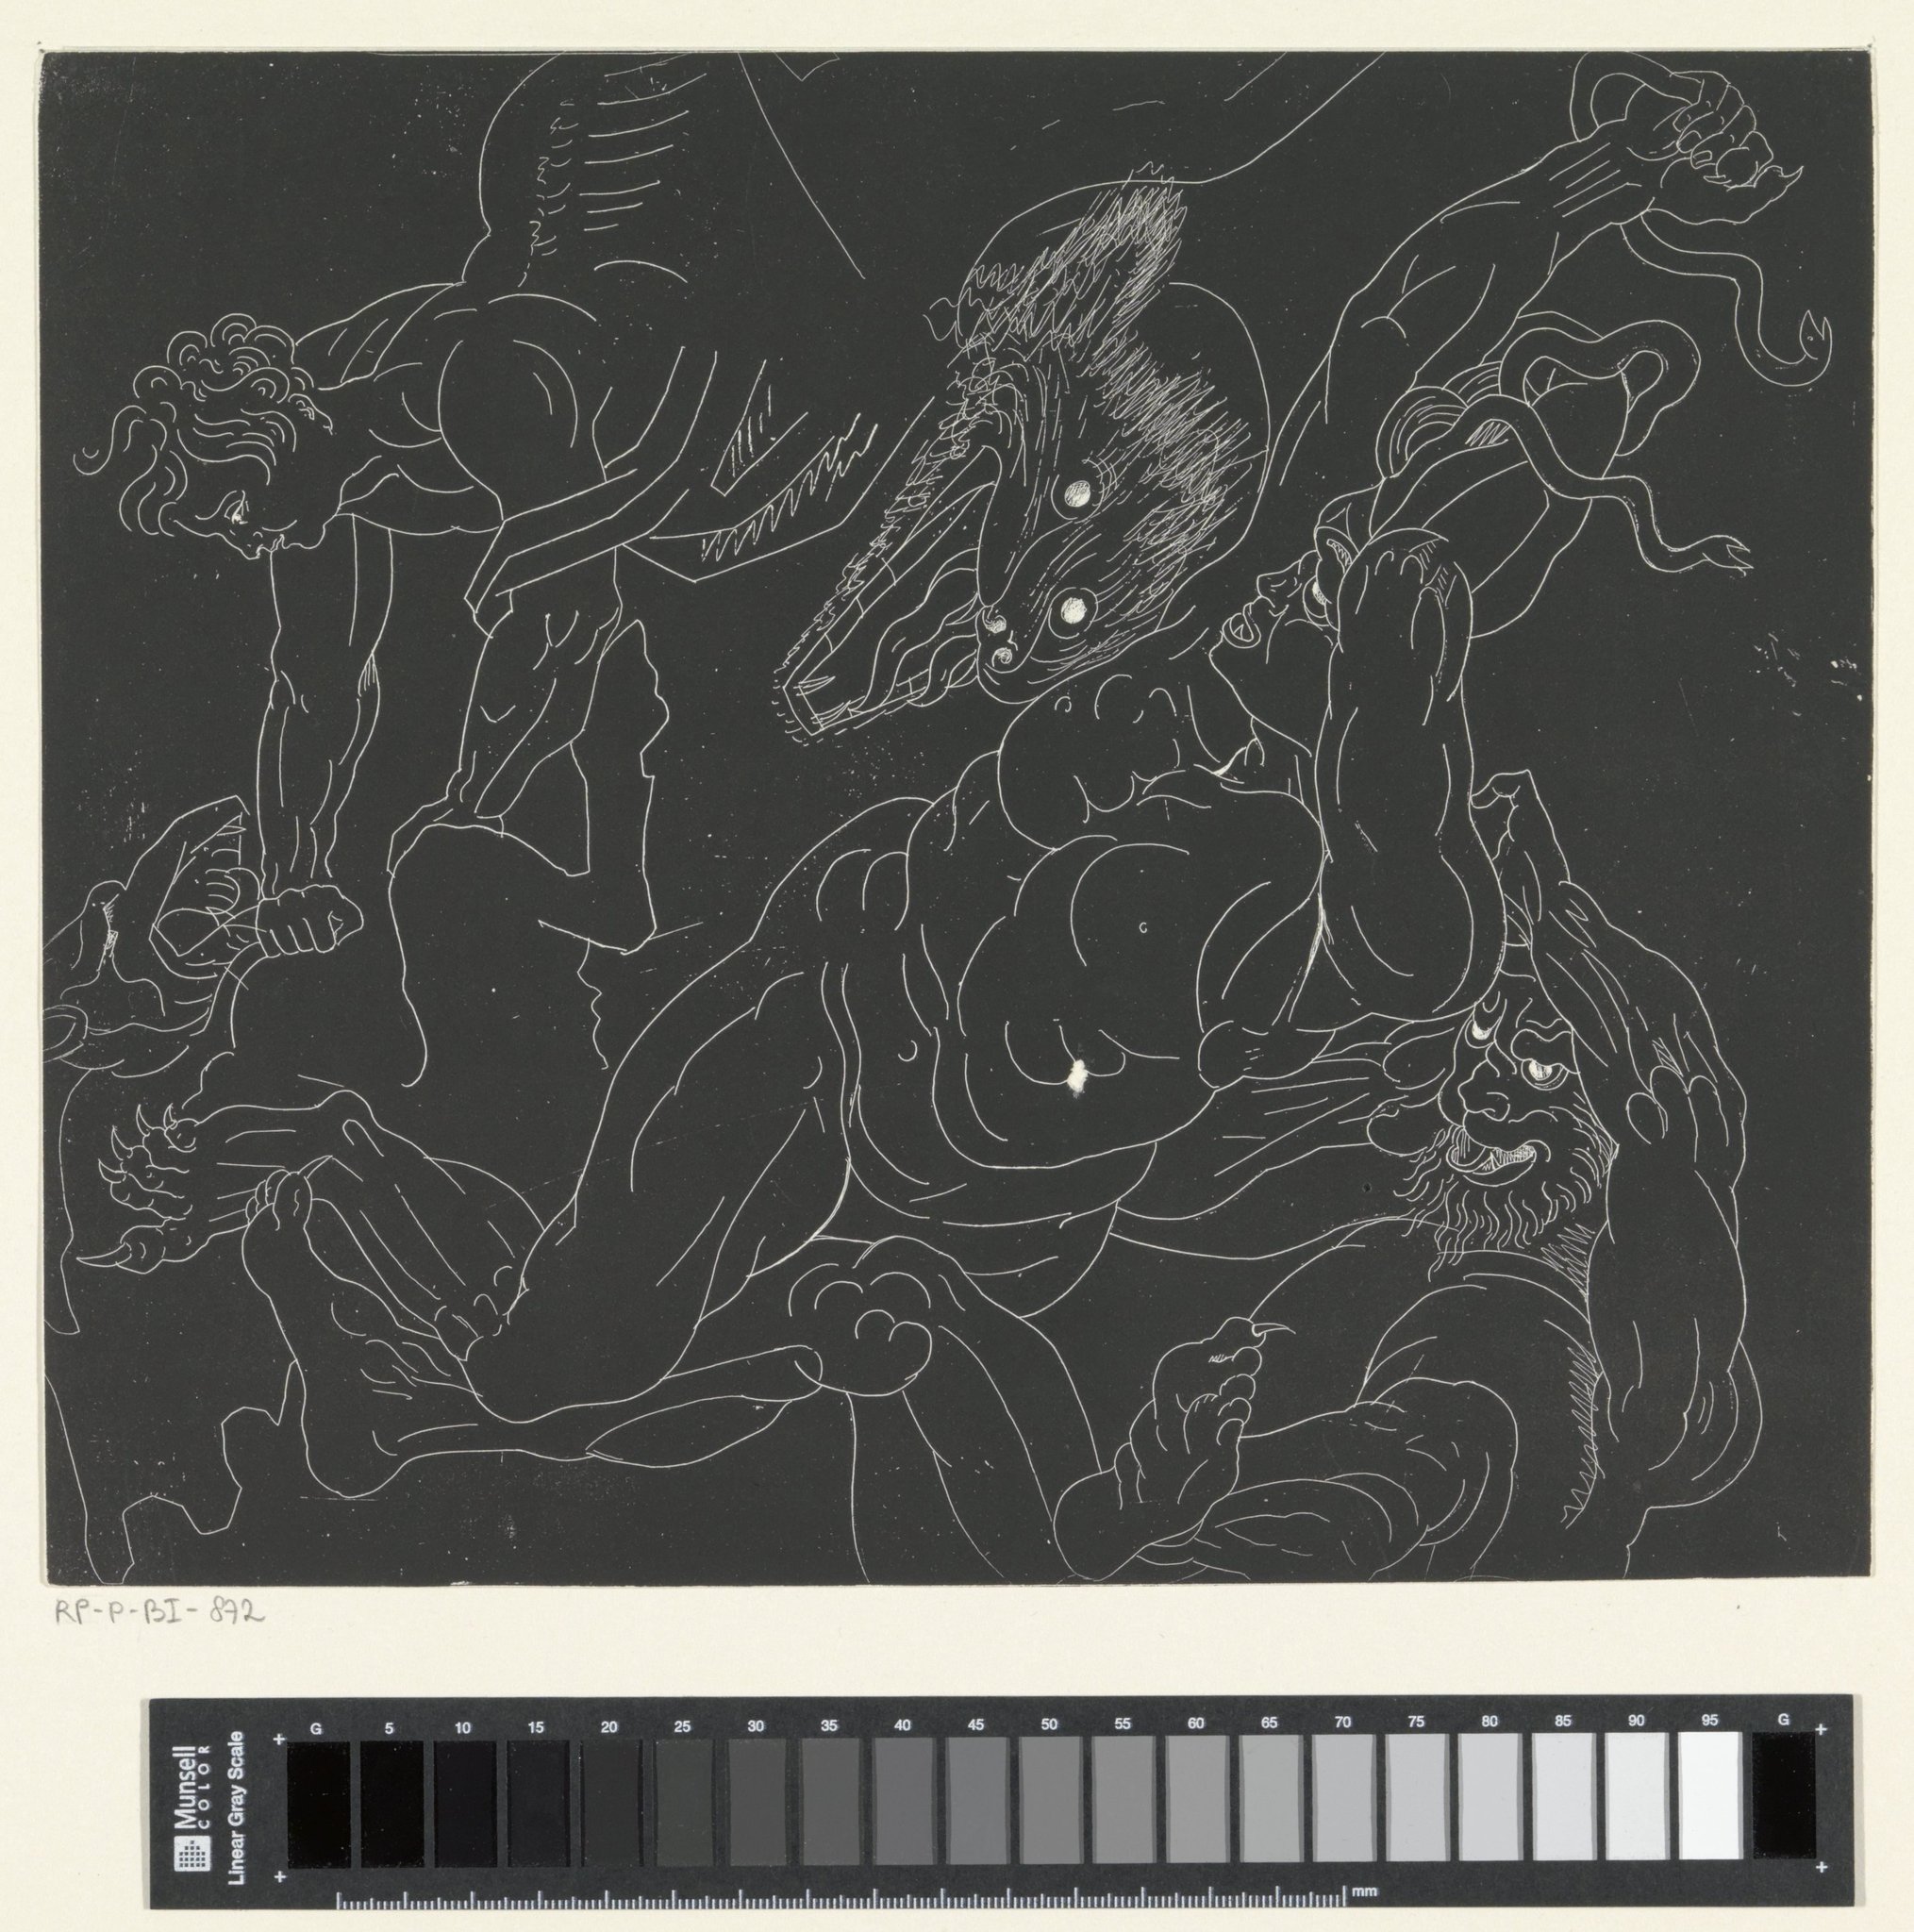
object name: print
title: Gevecht tussen engelen en monsters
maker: jonkheer isaac lambertus cremer van den berch van heemstede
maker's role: print maker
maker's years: 1811-1879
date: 1829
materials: paper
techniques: etching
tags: angels fighting against other evil powers, fabulous animals (sometimes wrongly called 'grotesques'); 'mostri' (ripa), man struggling with animals, angels and devils fighting over the soul, angels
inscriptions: collector's mark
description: Links heeft een engel de bek van een monster vast. In het midden een mensfiguur met ontbloot torso. In zijn uitgestrekte armen heeft hij een slang. In het midden een kop van een wolf of monster met wijd opengesperde bek.